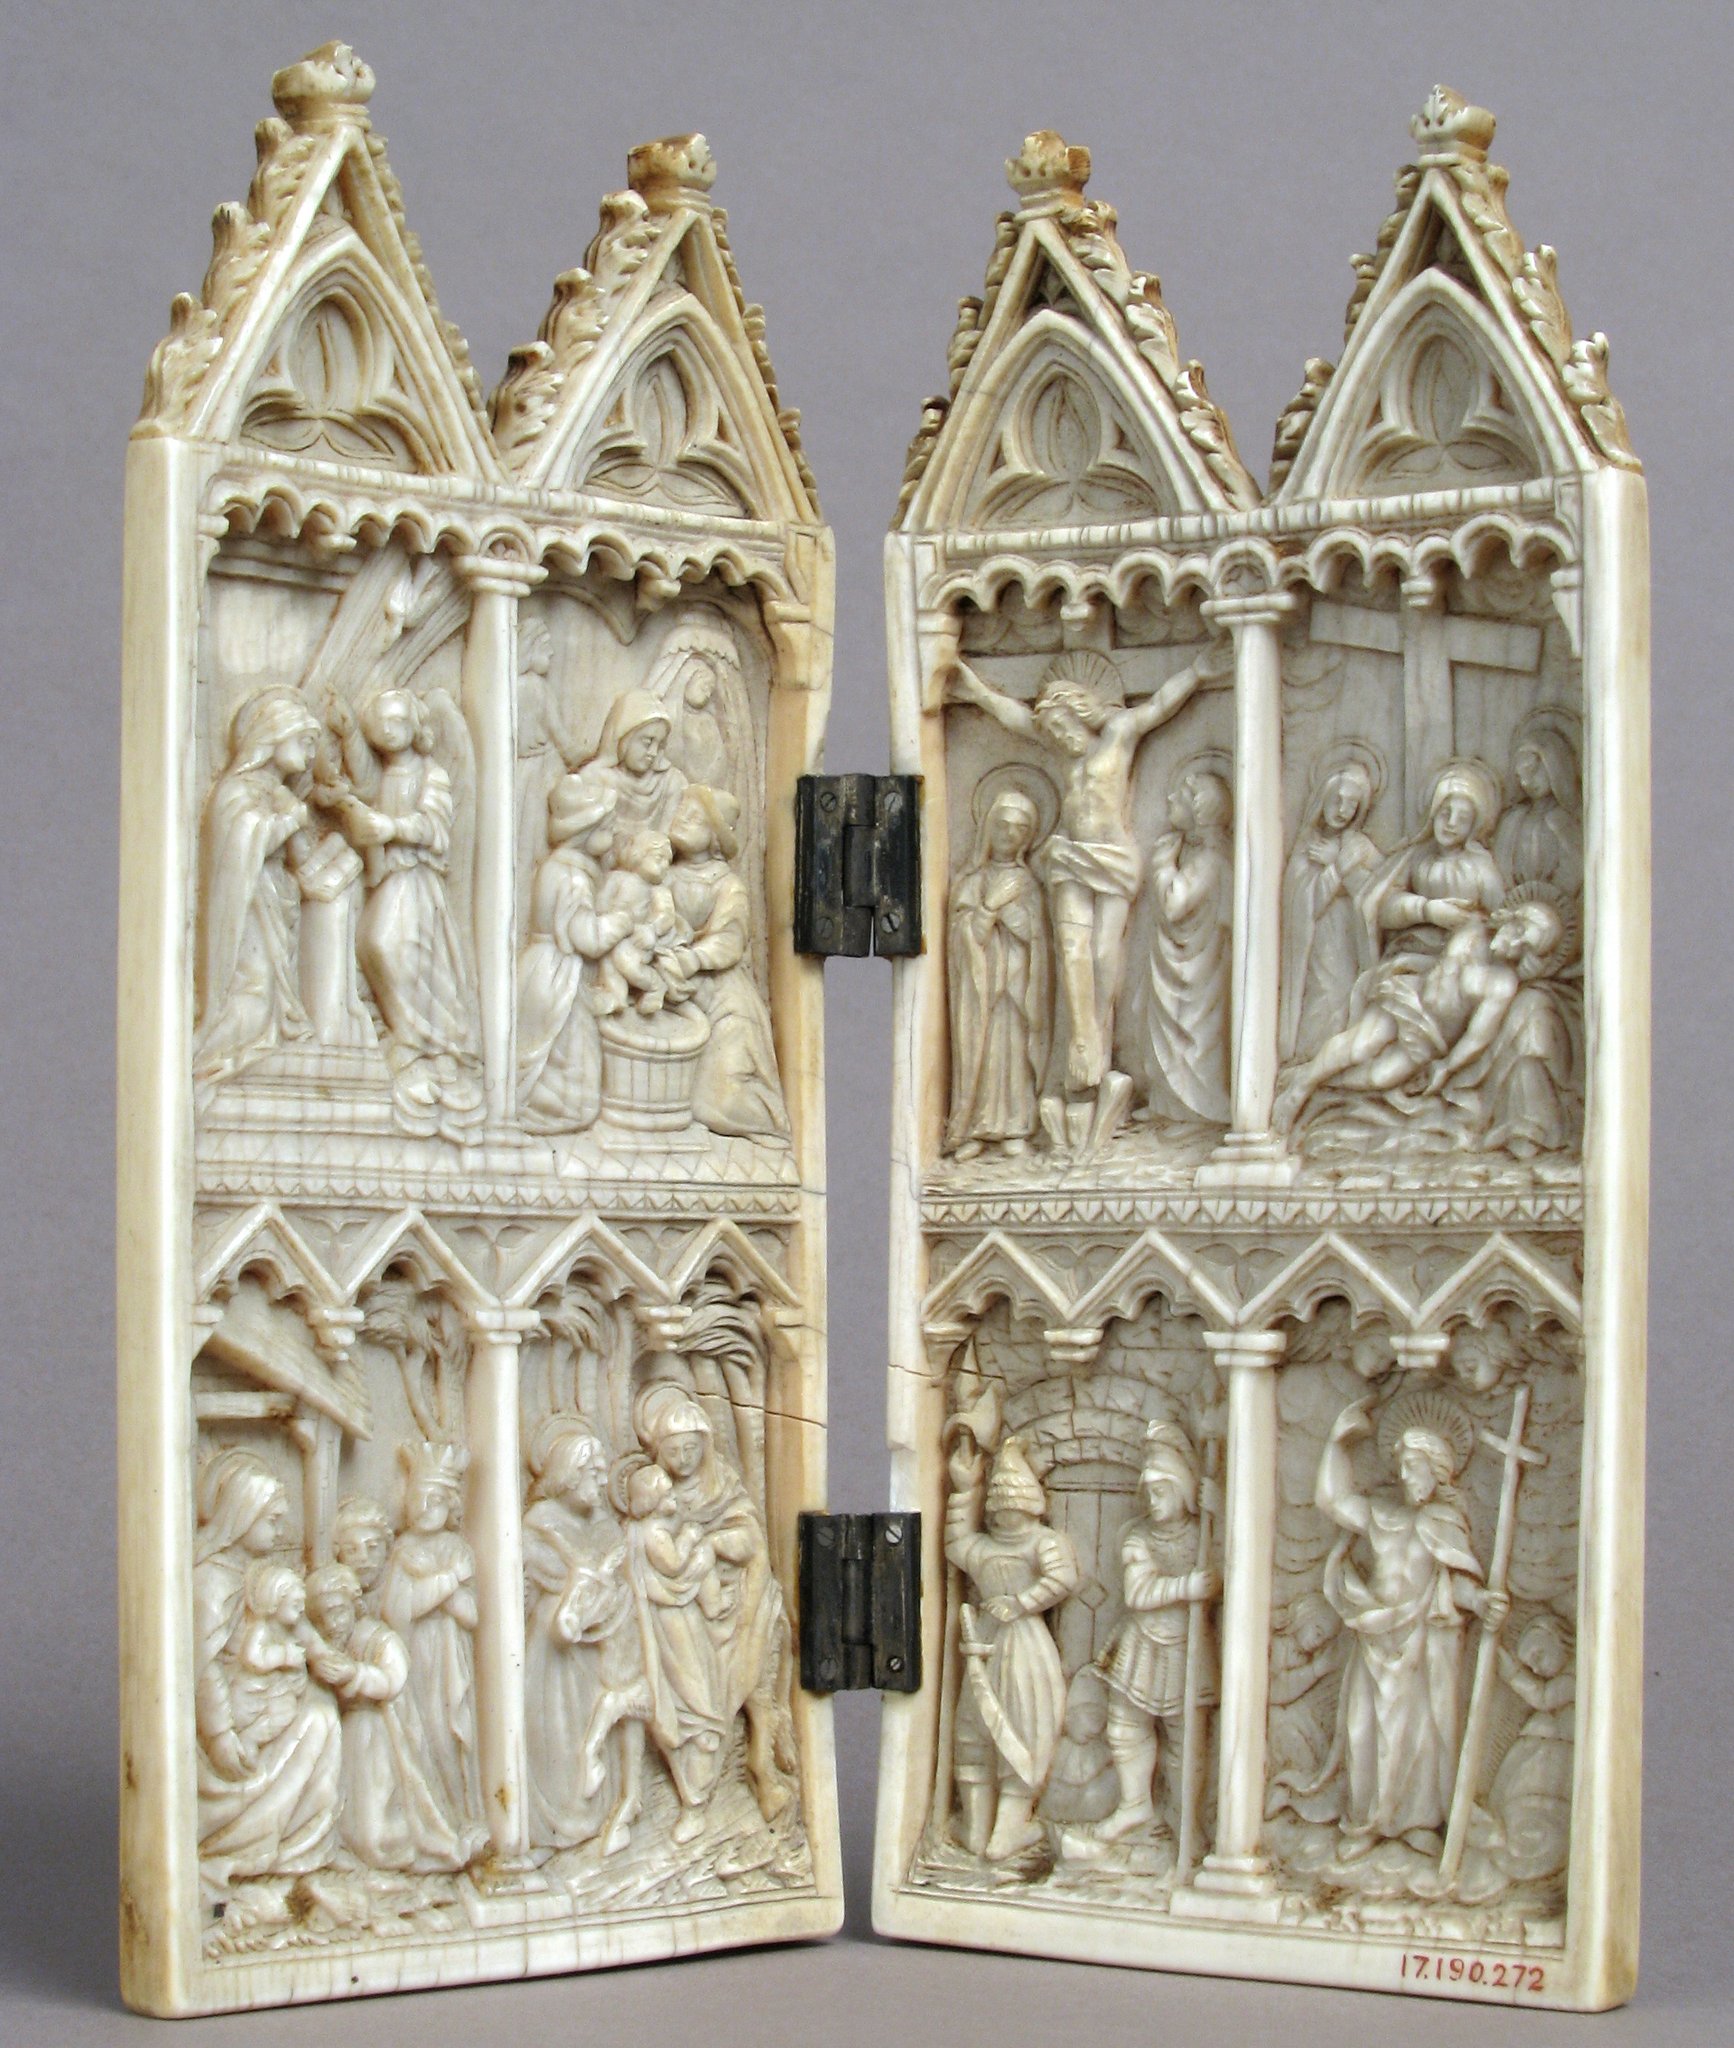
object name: diptych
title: Diptych with Scenes from the Life of Christ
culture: european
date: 1801-1900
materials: ivory, metal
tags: men,women,christ,crucifixion